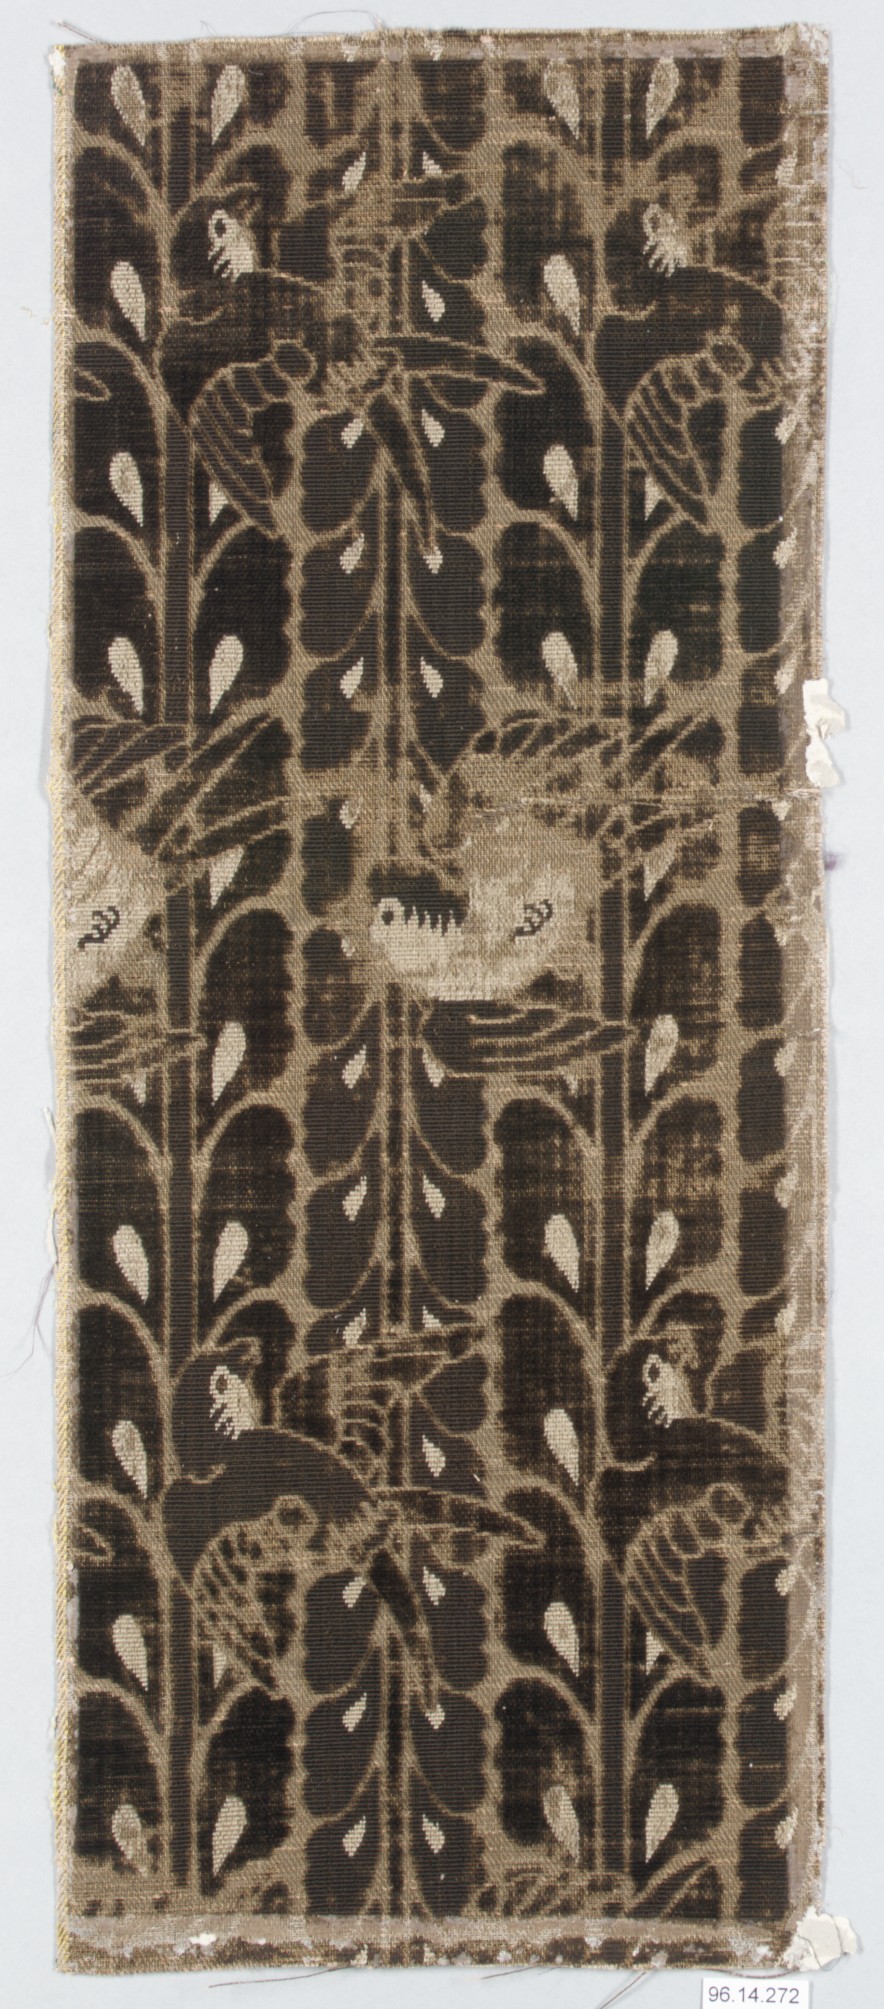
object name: piece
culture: japanese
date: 1701-1900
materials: silk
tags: birds